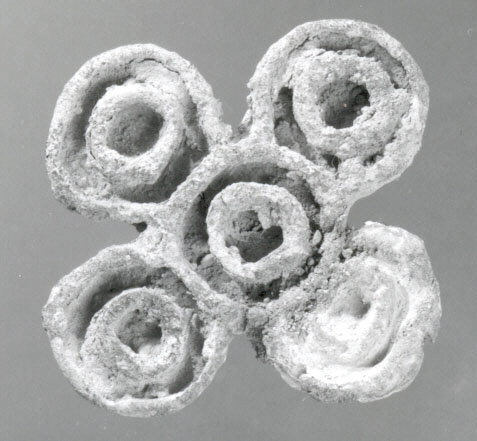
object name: stamp seal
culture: bactria-margiana archaeological complex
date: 2333-1668 BCE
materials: copper alloy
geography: bactria-margiana